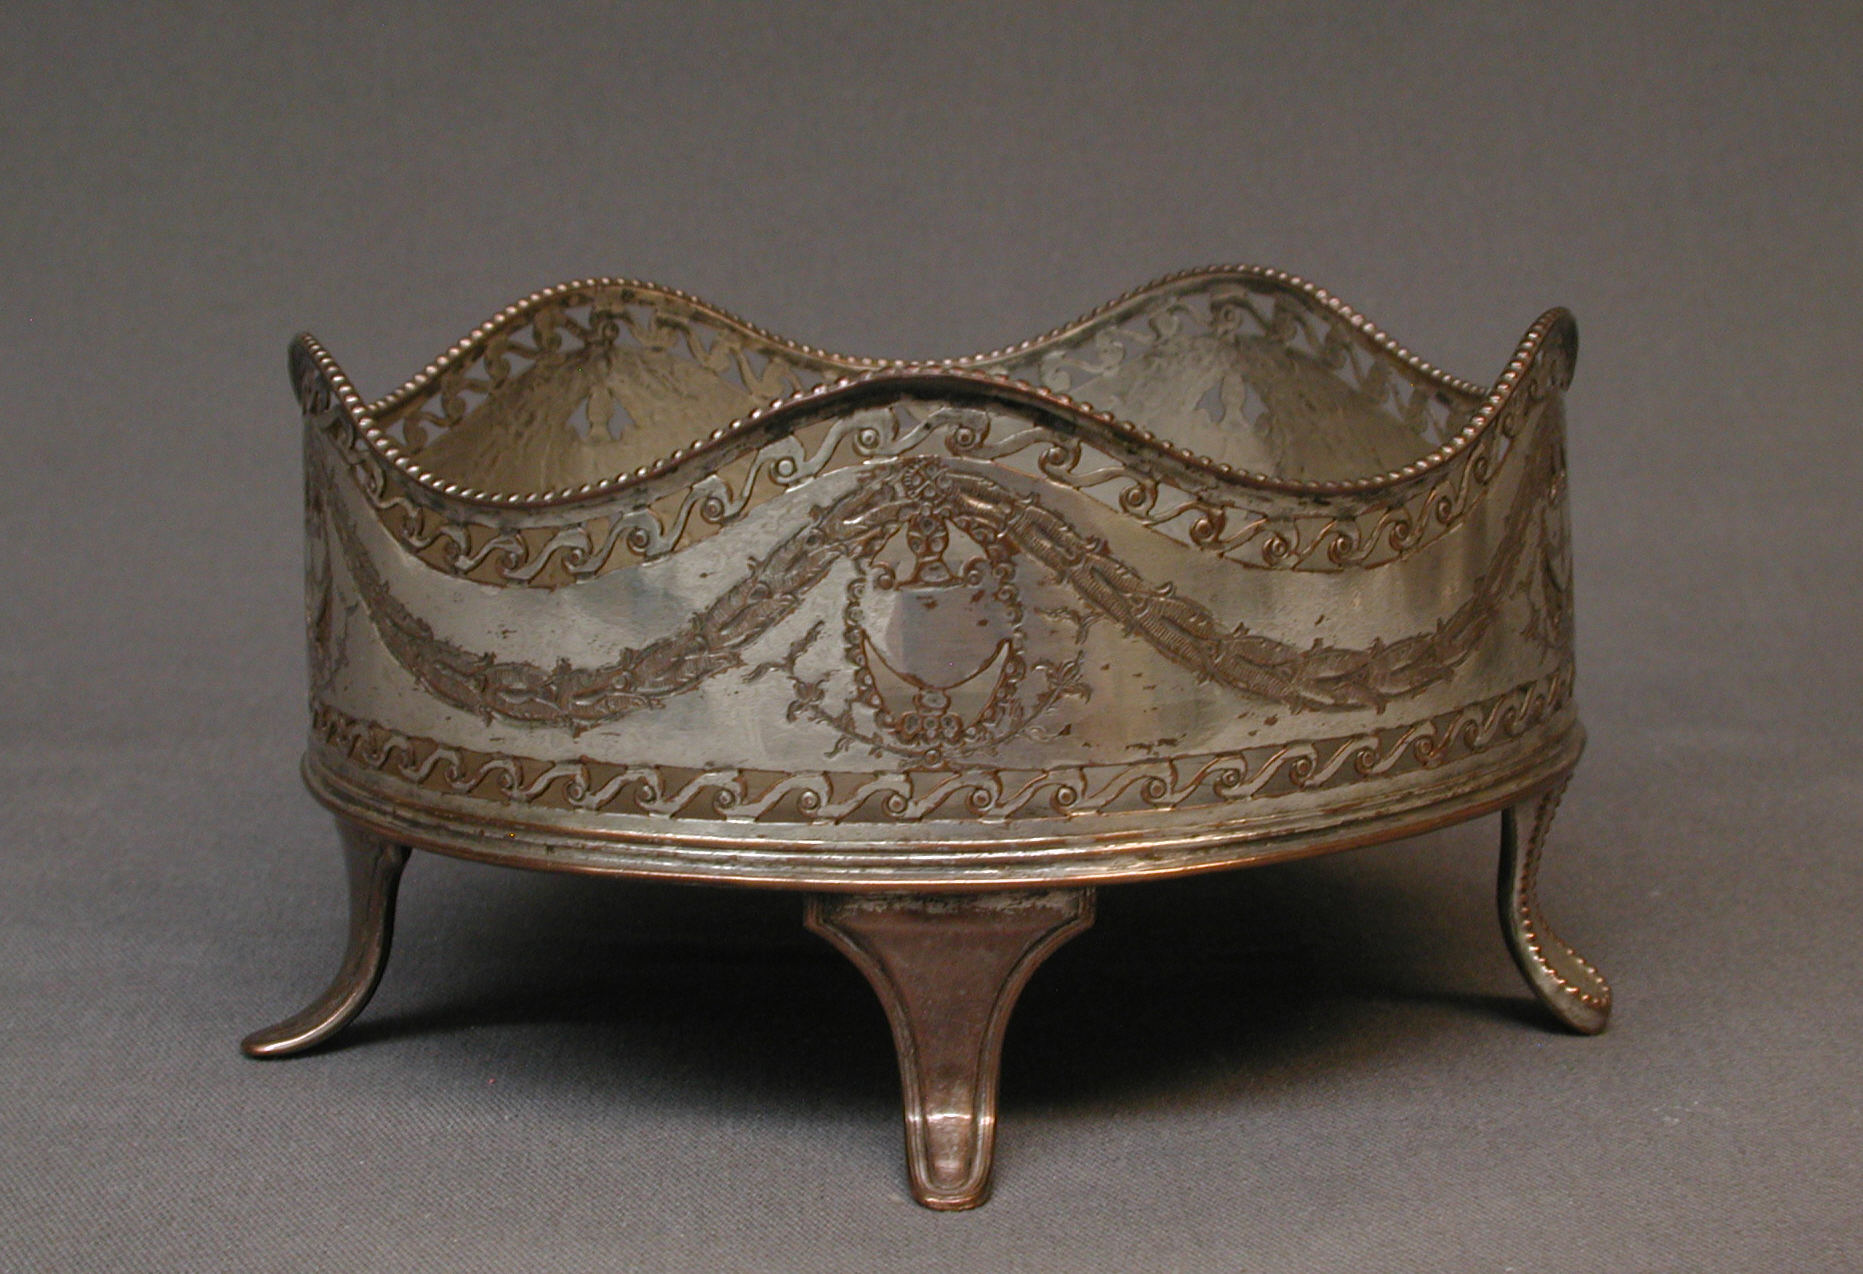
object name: coaster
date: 1785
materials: metal